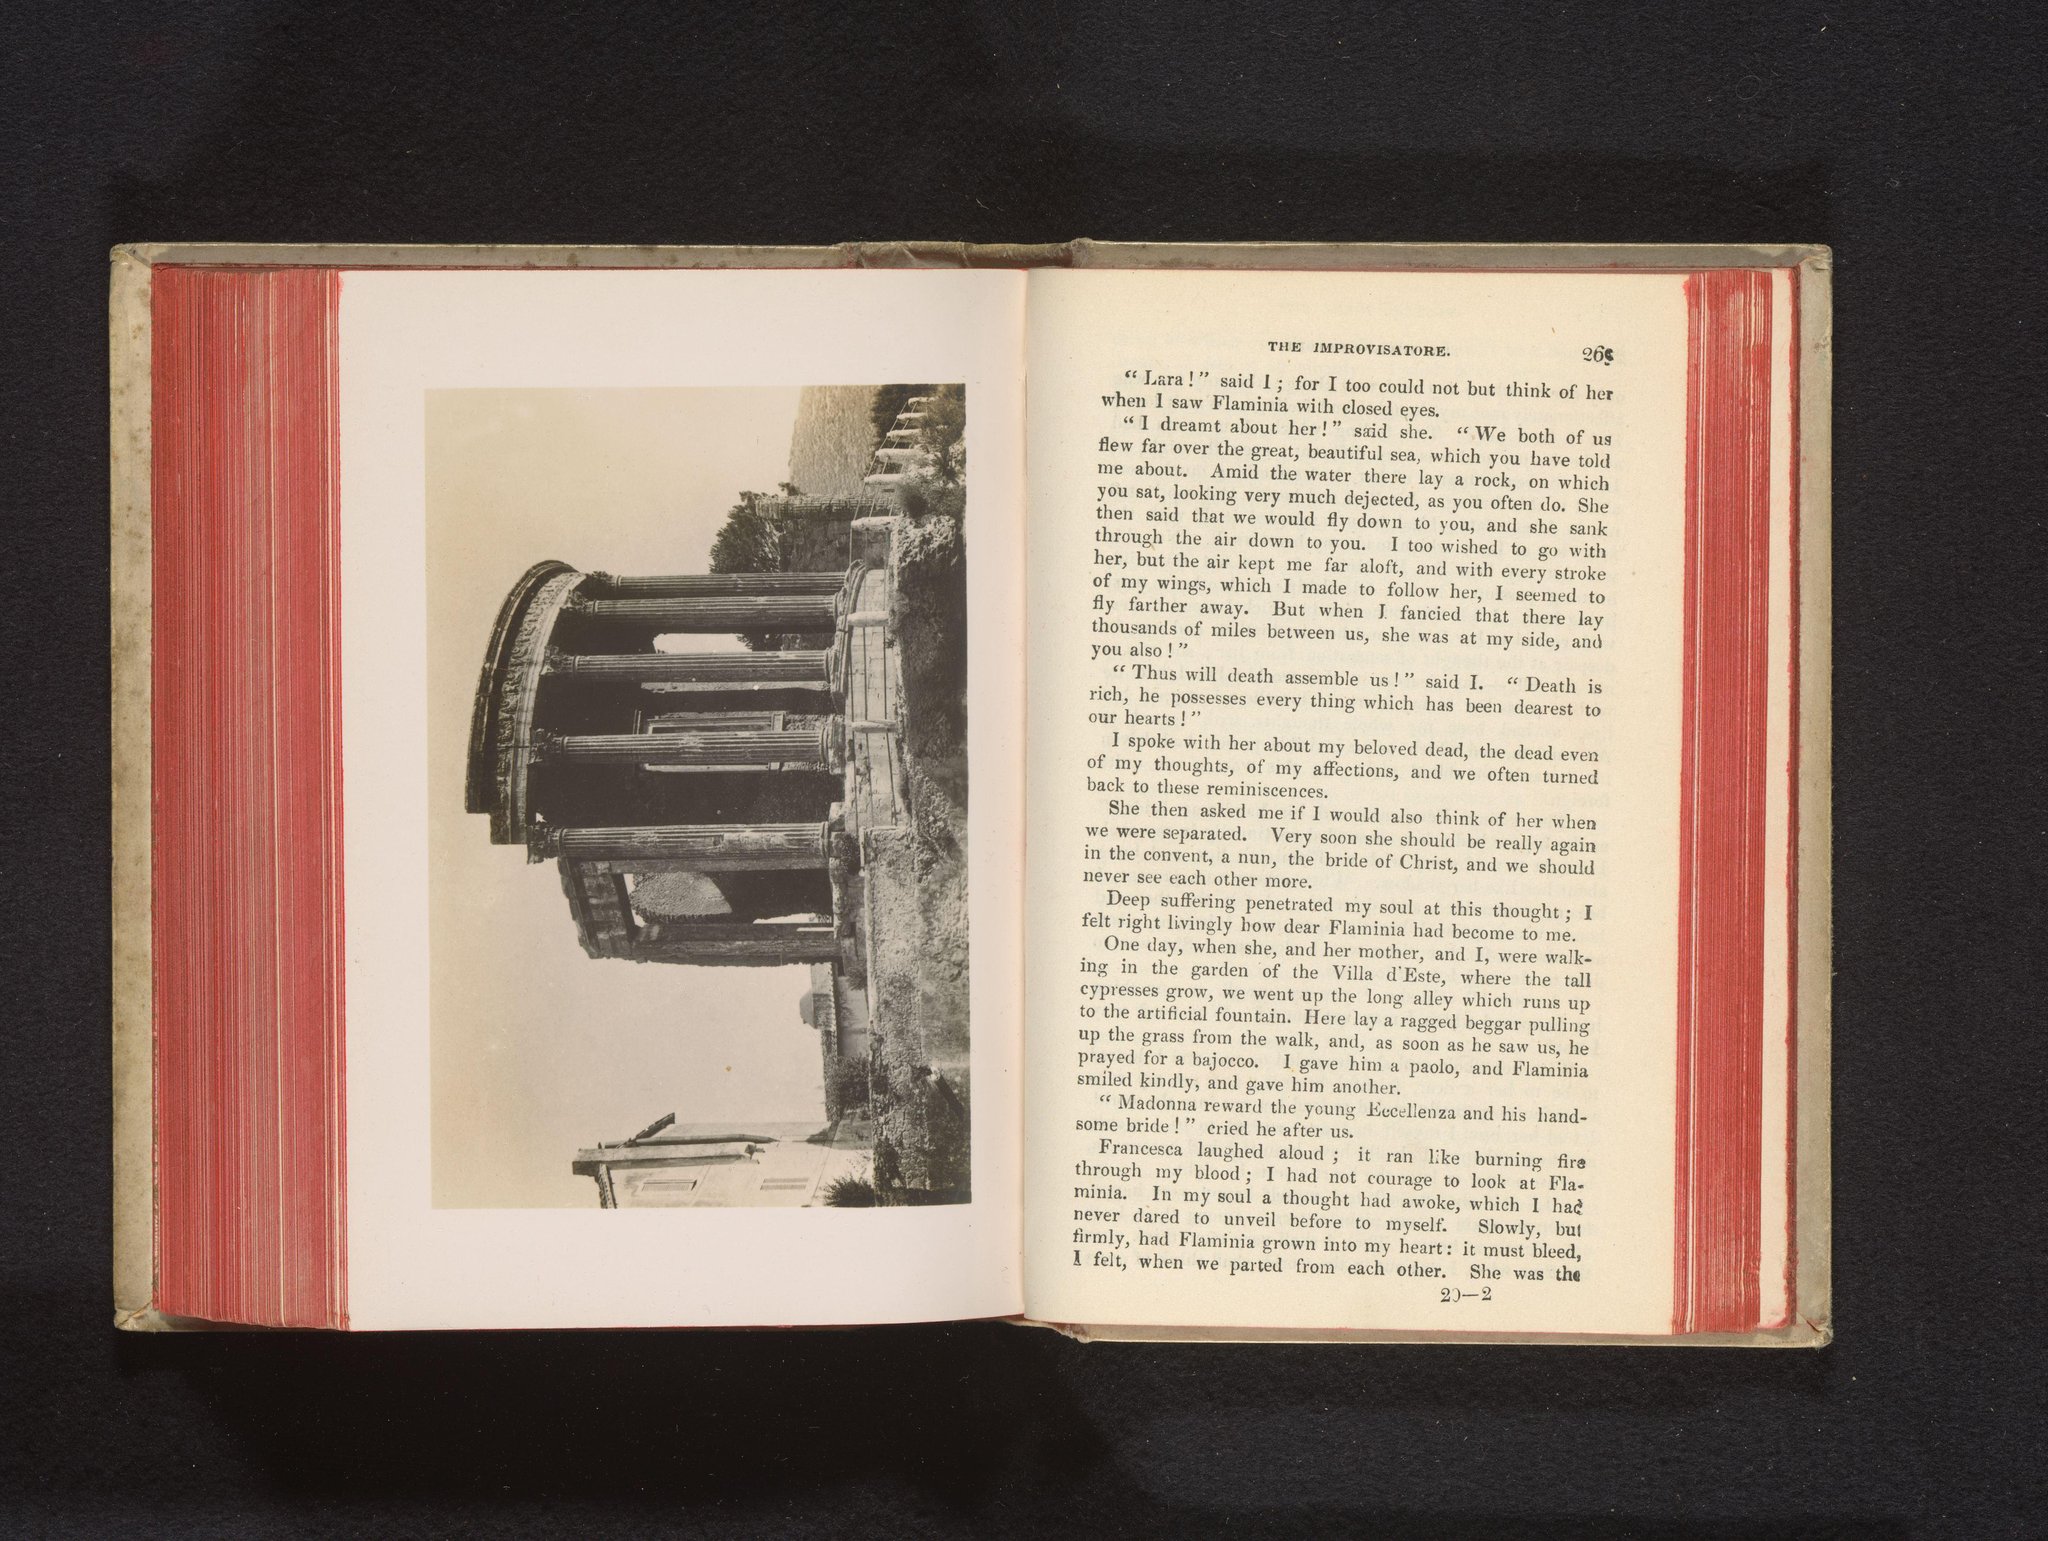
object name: photograph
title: Ruïne van de Tempel van Vesta te Tivoli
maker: Anonymous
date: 1870-1880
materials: photographic support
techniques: gelatin silver print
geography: tivoli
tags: ruin of a building ~ architecture, temple, shrine ~ roman religion